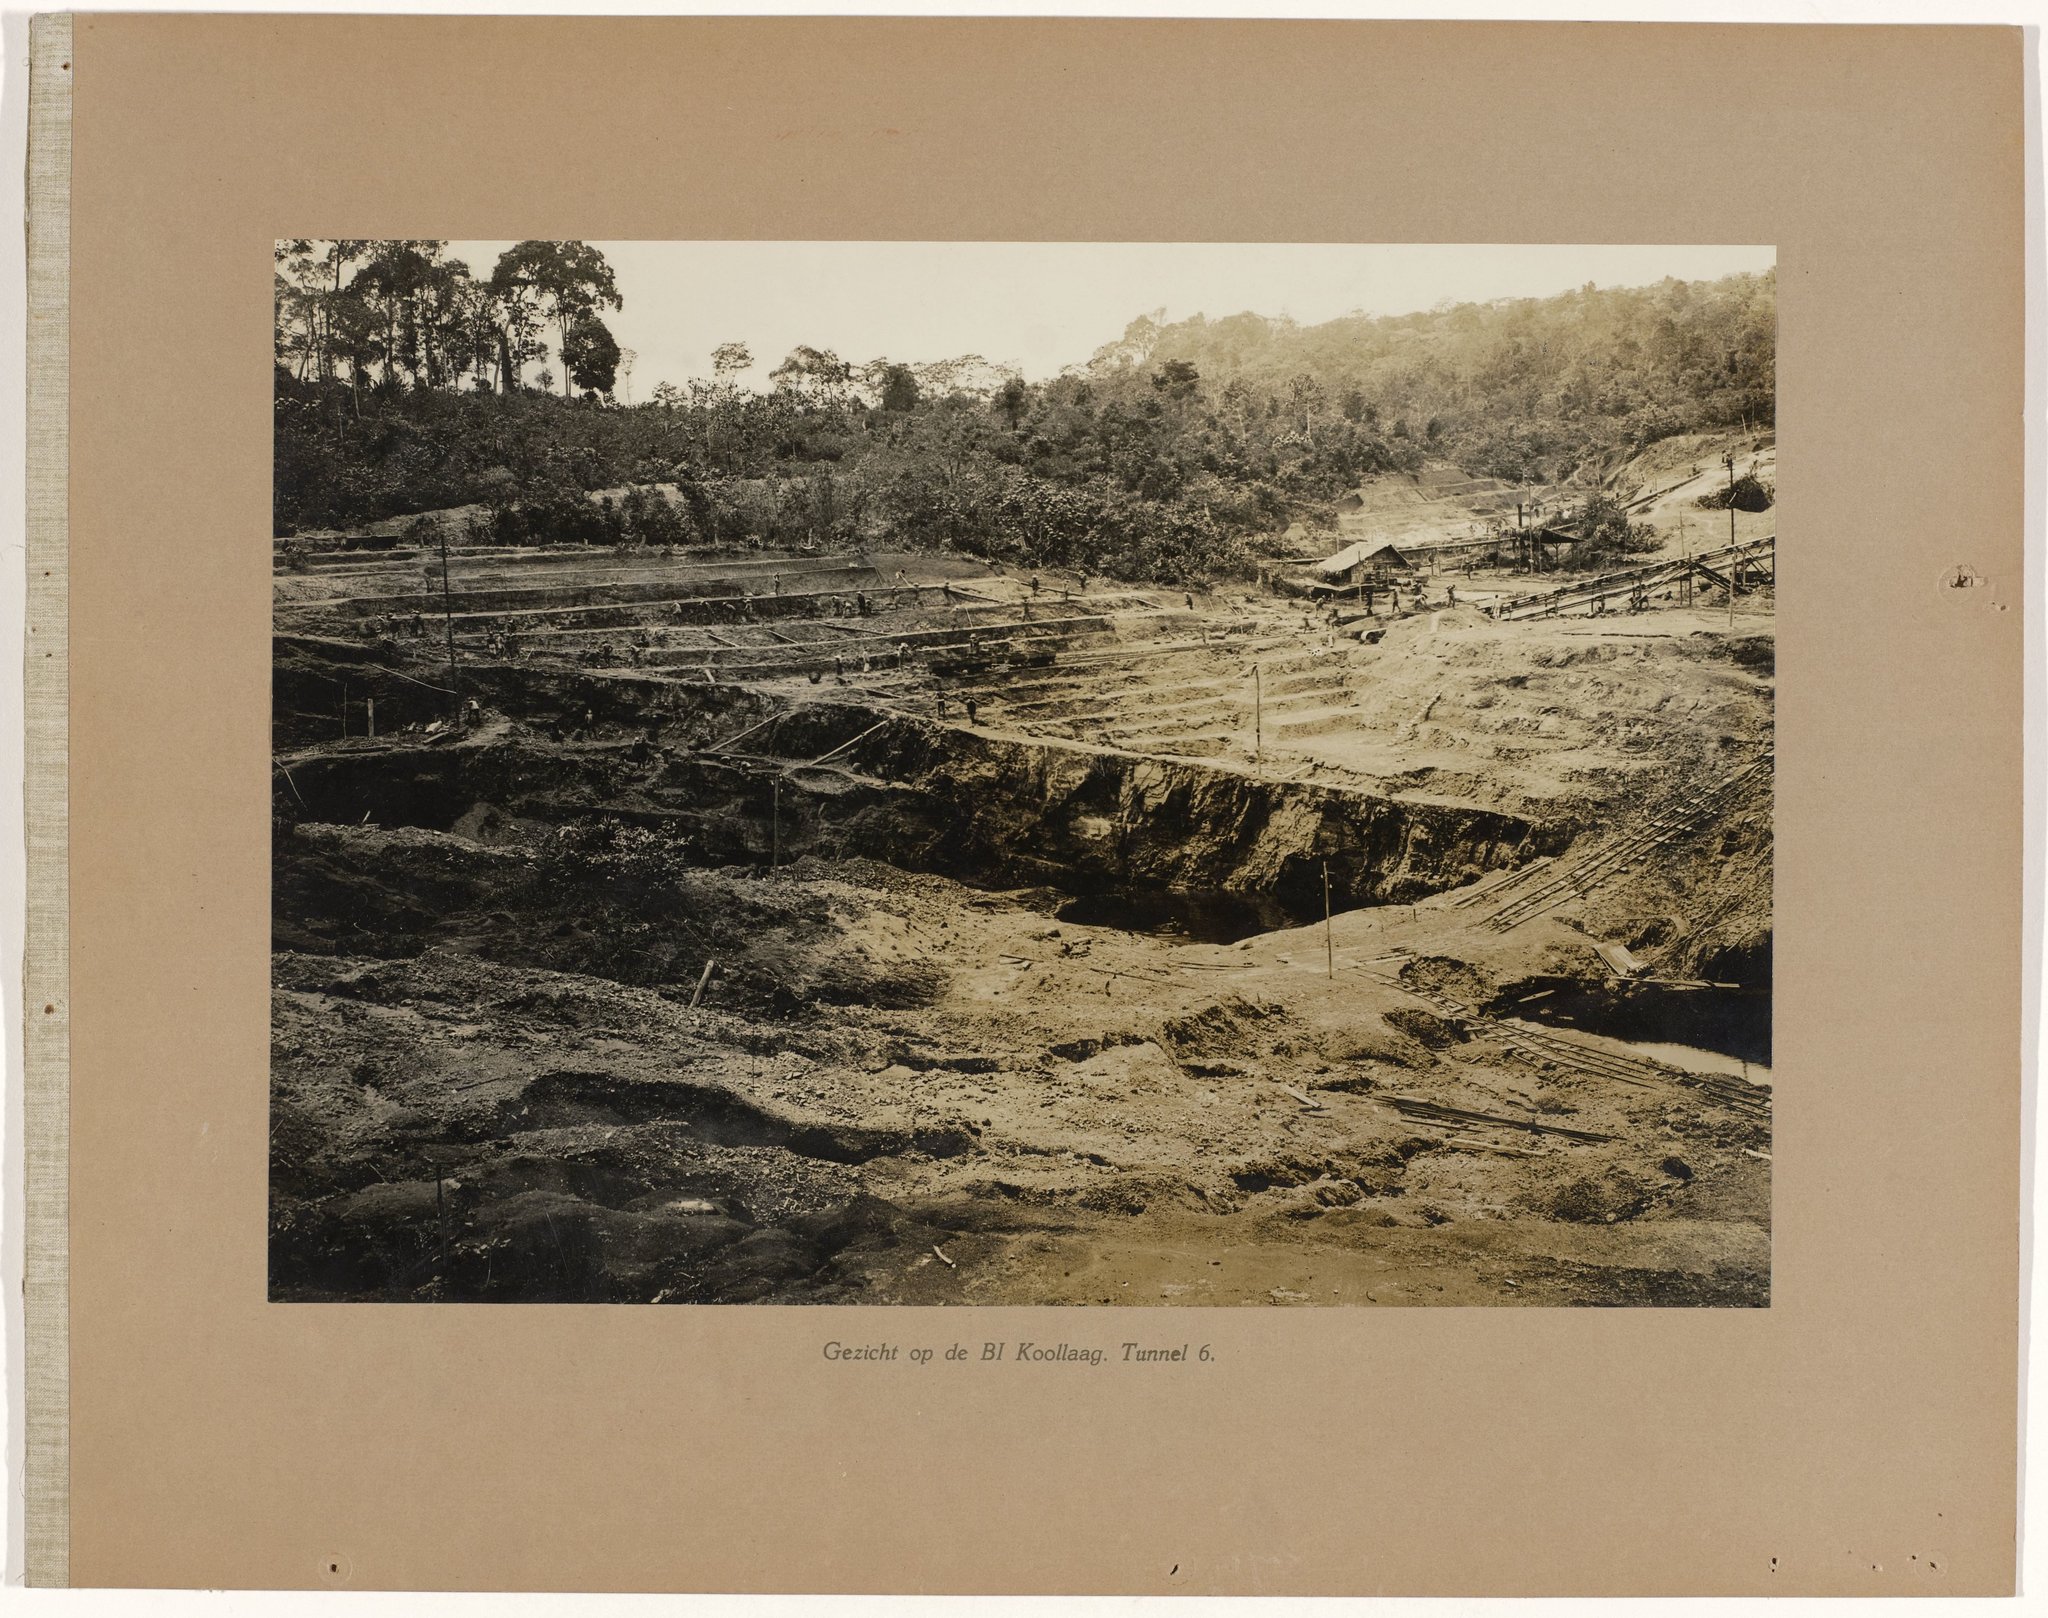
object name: photograph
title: Gezicht op de B1 Koollaag. Tunnel 6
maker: Anonymous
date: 1921-1922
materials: photographic support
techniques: gelatin silver print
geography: bukit asam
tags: colonial system, anthracite, hard coal, opencast mine; strip mining (+ coal), sumatra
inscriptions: inscription: ‘Gezicht op de B1 Koollaag. Tunnel 6.’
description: Gezicht op een blootliggende koollaag in de open mijn. Onderdeel van het losbladige fotoalbum aangeboden door het personeel van de Boekit-Asam Steenkolenmijnen op Sumatra aan de scheidende Ingenieur-Directeur H. Tromp op 7 januari 1922.